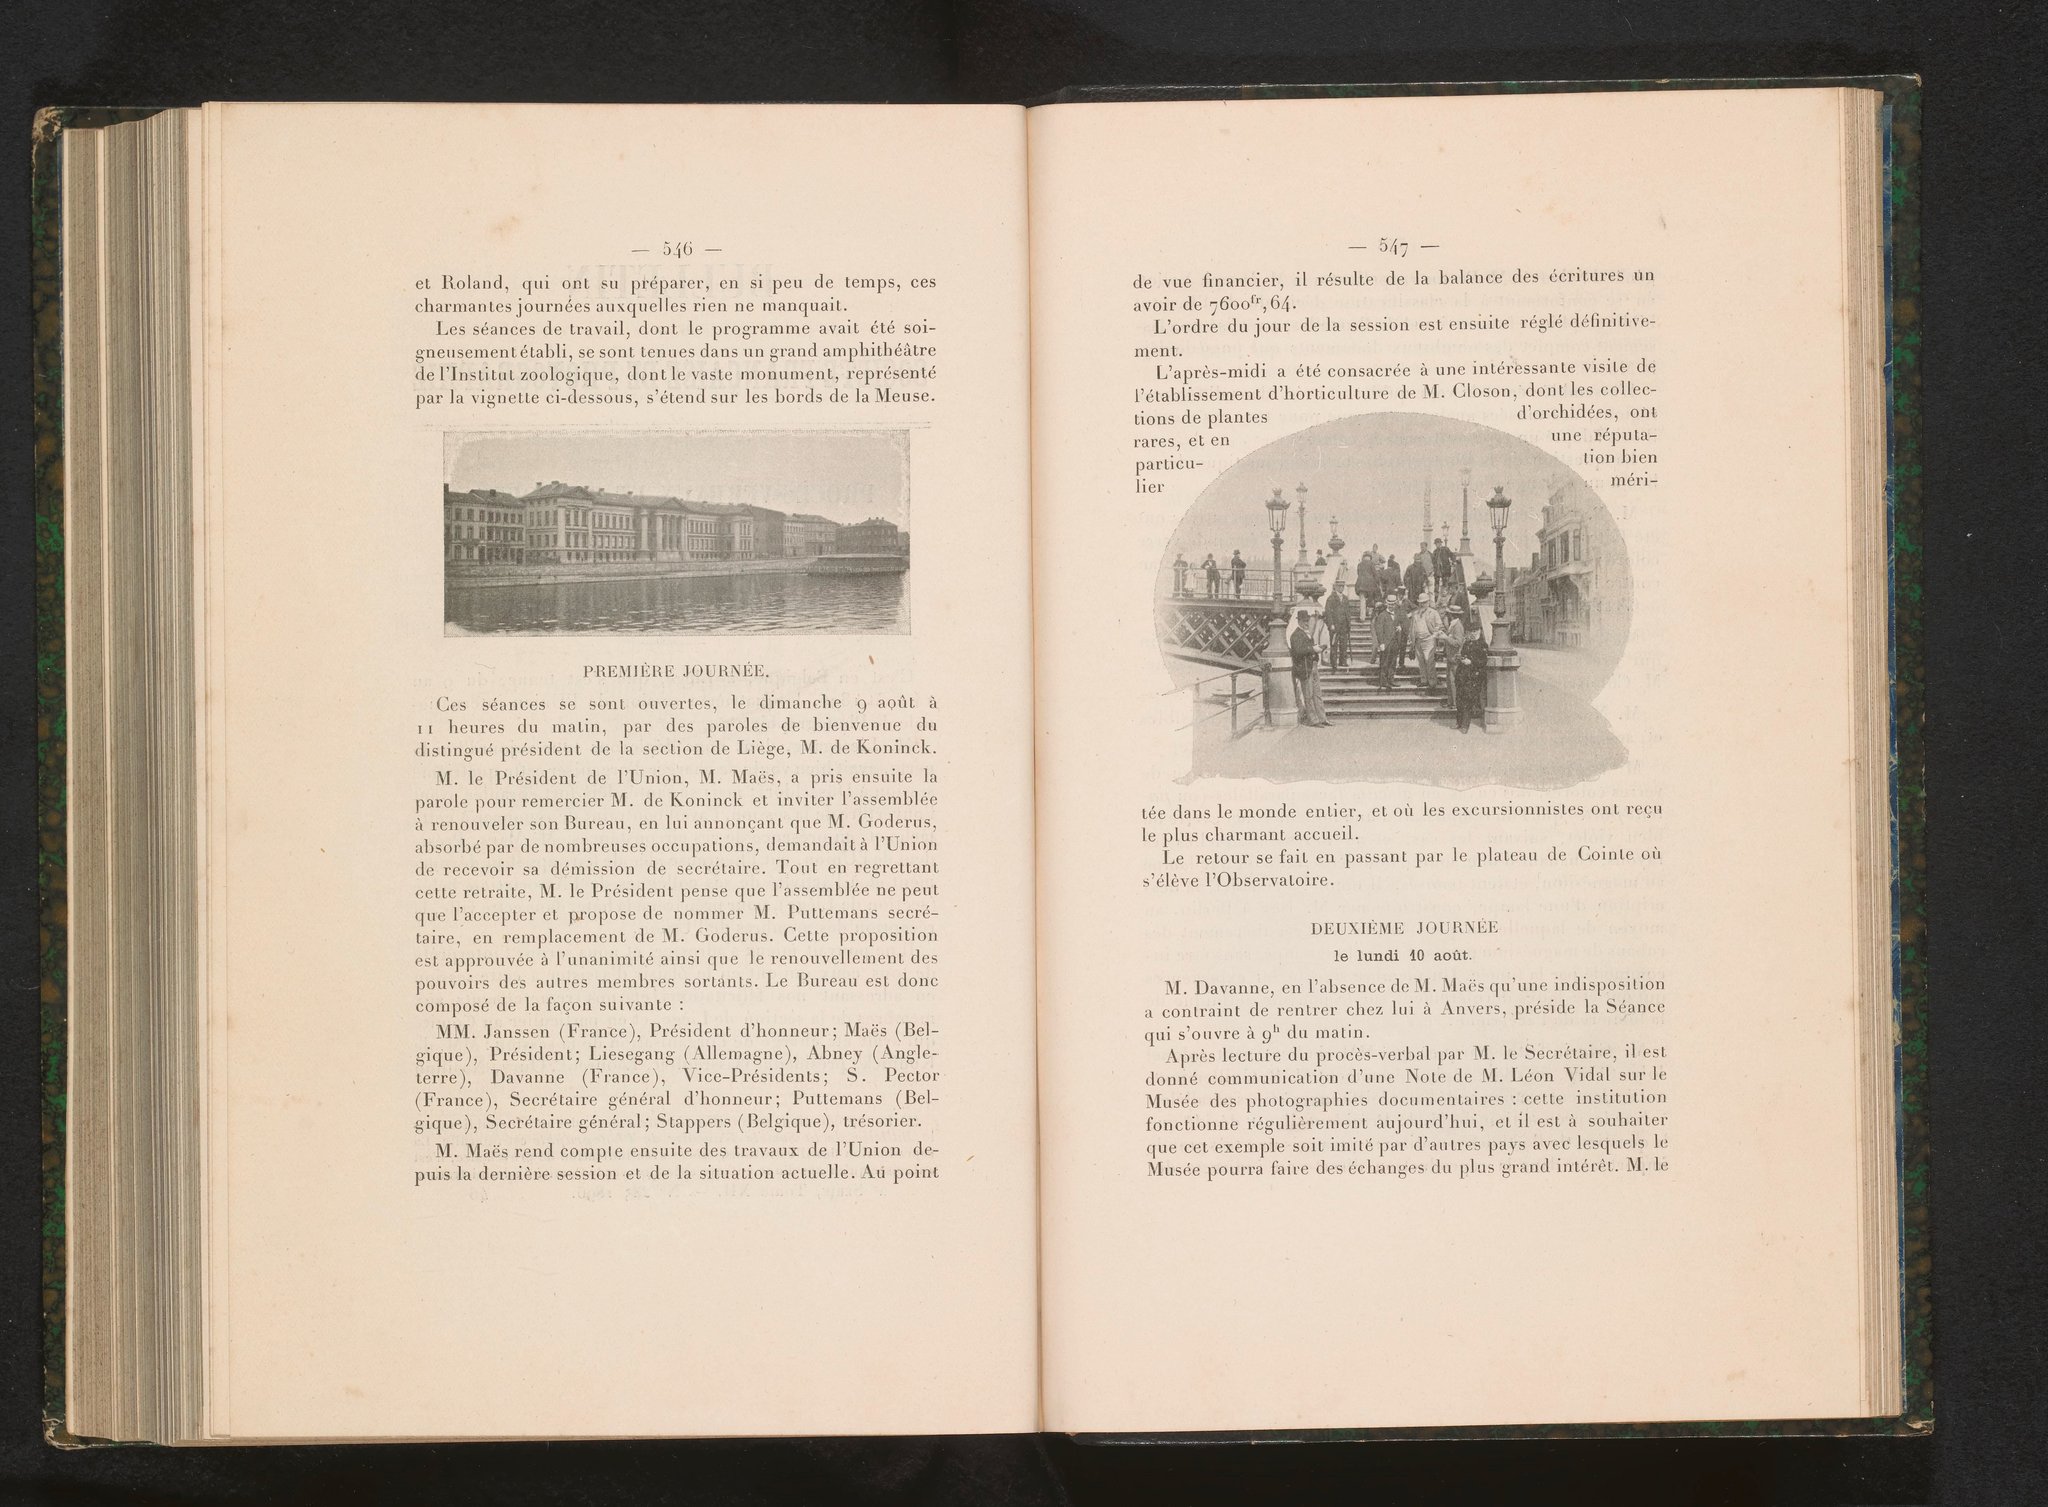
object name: photomechanical print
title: Leden van de Union International de Photographie op een trap te Luik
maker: Anonymous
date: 1896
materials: paper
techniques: autotype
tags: staircase, historical persons (portraits and scenes from the life)